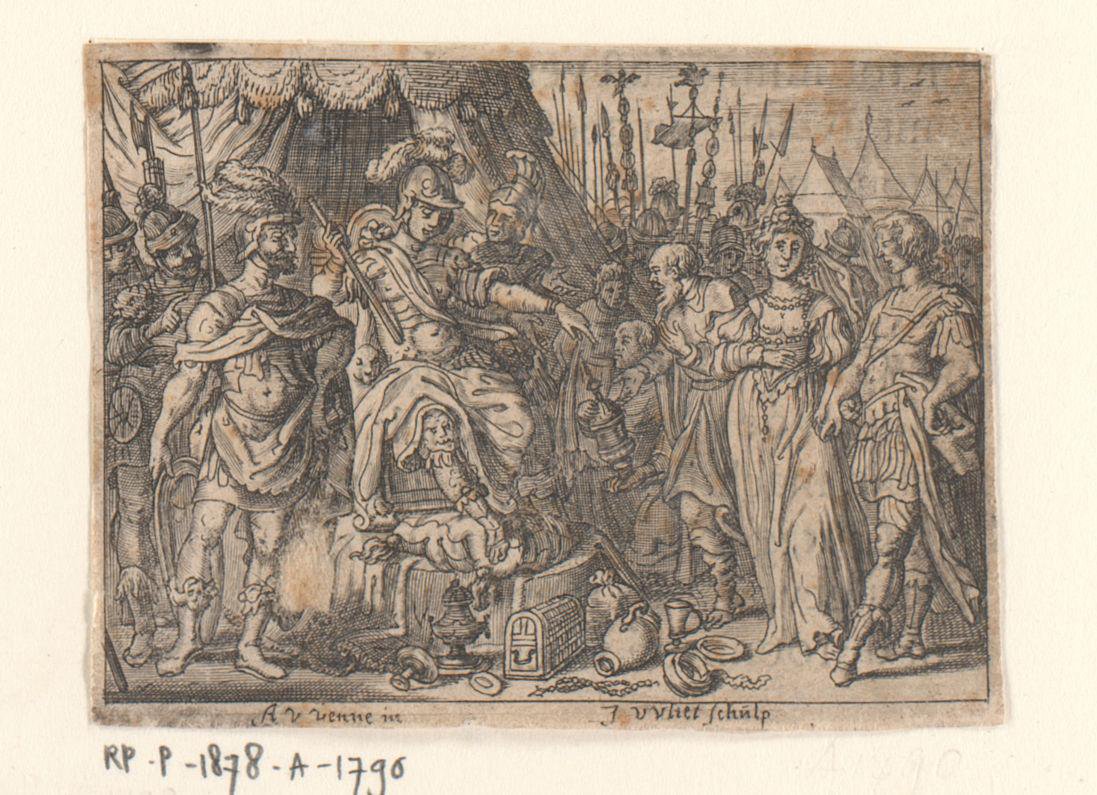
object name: book illustration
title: Scipio en de bruid van Numantia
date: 1628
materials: paper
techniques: engraving, etching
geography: the hague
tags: politician, (military) camp with tents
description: Prent gebruikt als boekillustratie in: Cats, Jacob. Self-stryt, dat is Onderlinge worstelinghe van goede ende quade gedachten. Den Haag: Adriaen van de venne en Joost Ockers, 1628.